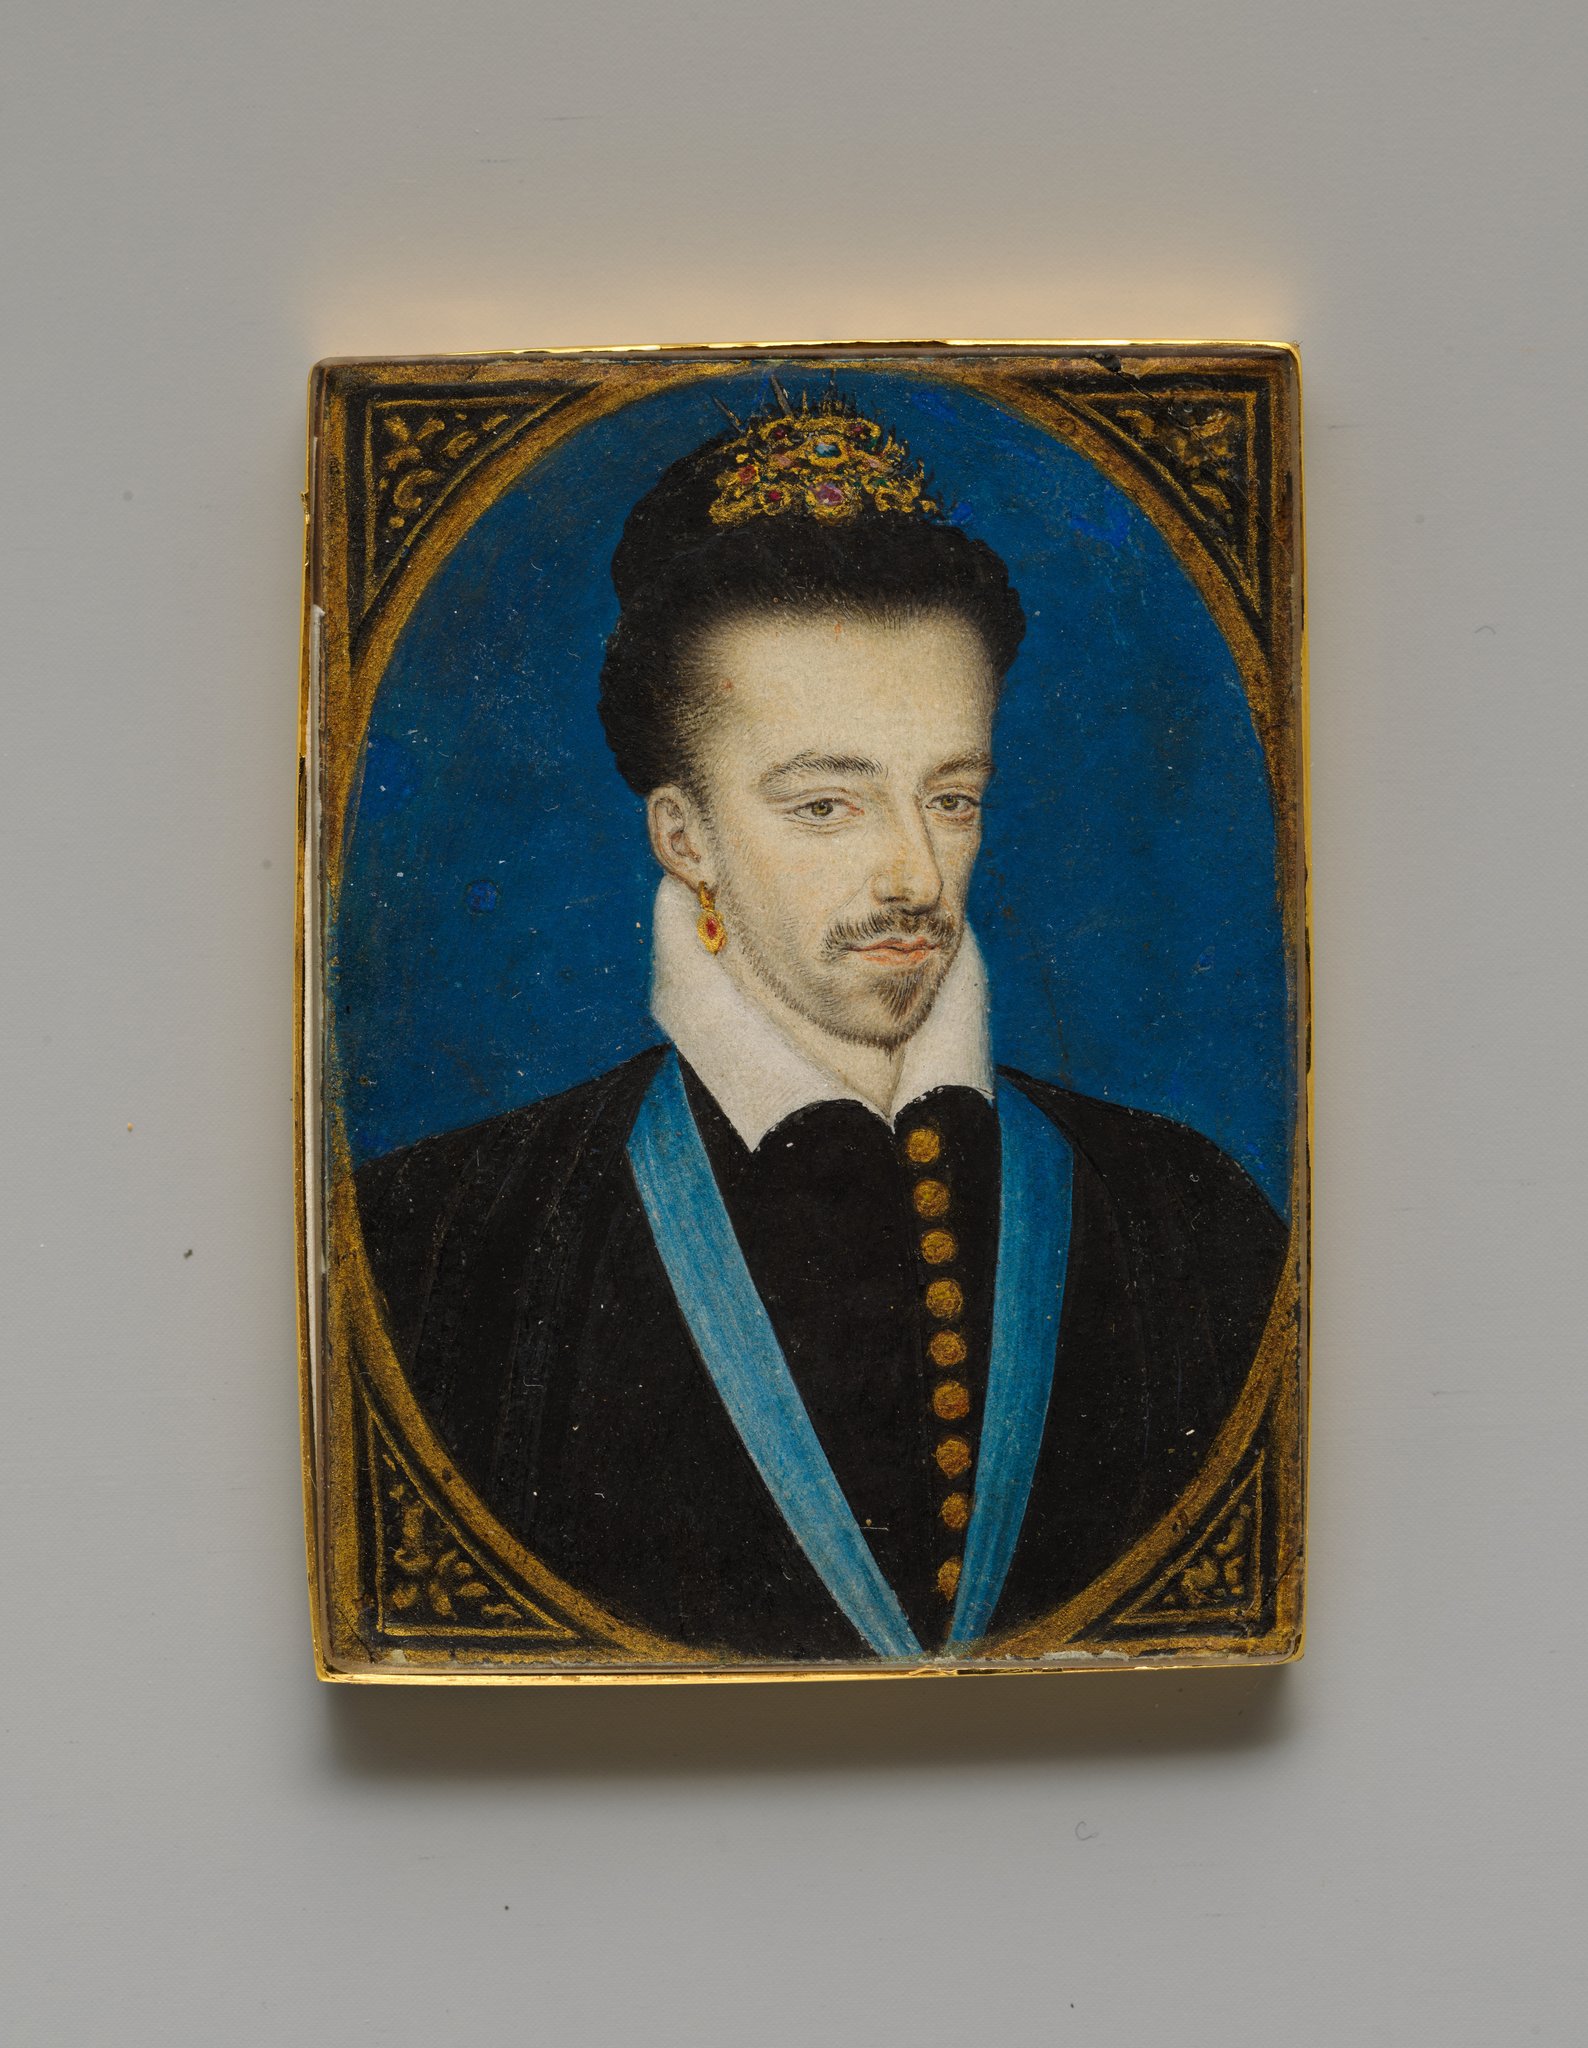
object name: painting, miniature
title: Henry III (1551–1589), King of France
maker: françois clouet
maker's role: artist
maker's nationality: french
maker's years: 1536-1572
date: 1578-1599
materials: parchment, wood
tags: kings,men,portraits